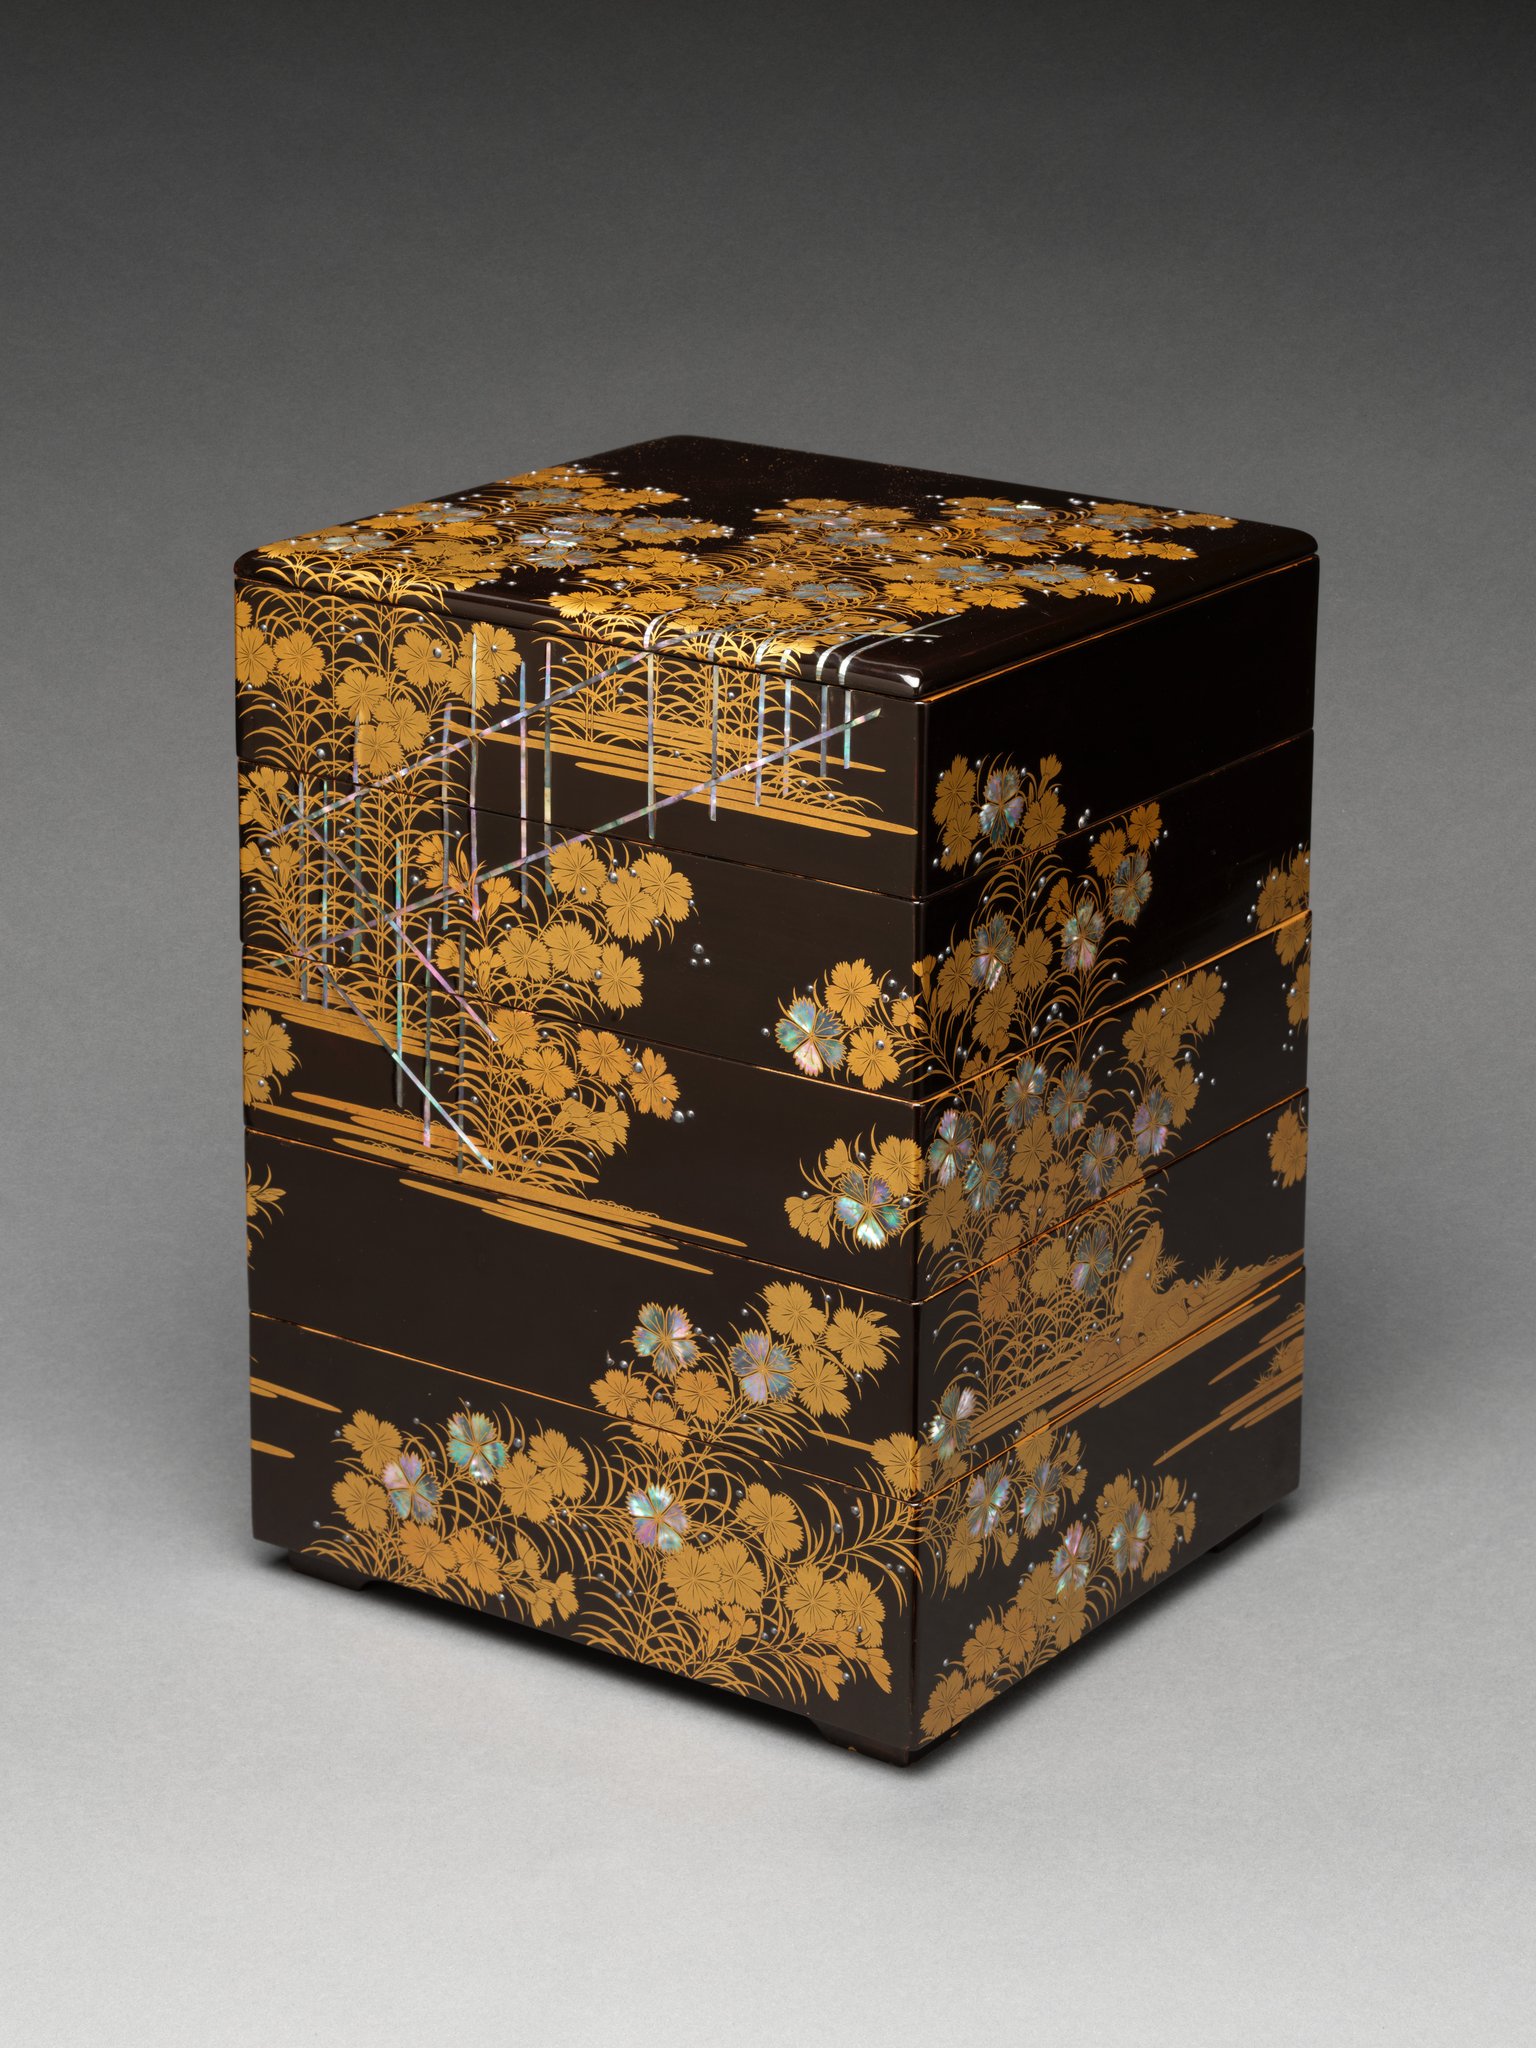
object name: picnic box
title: Five-tiered picnic box with design of wild pinks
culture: japanese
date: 1701-1800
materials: gold, lacquer, mother of pearl, silver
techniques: inlay, maki